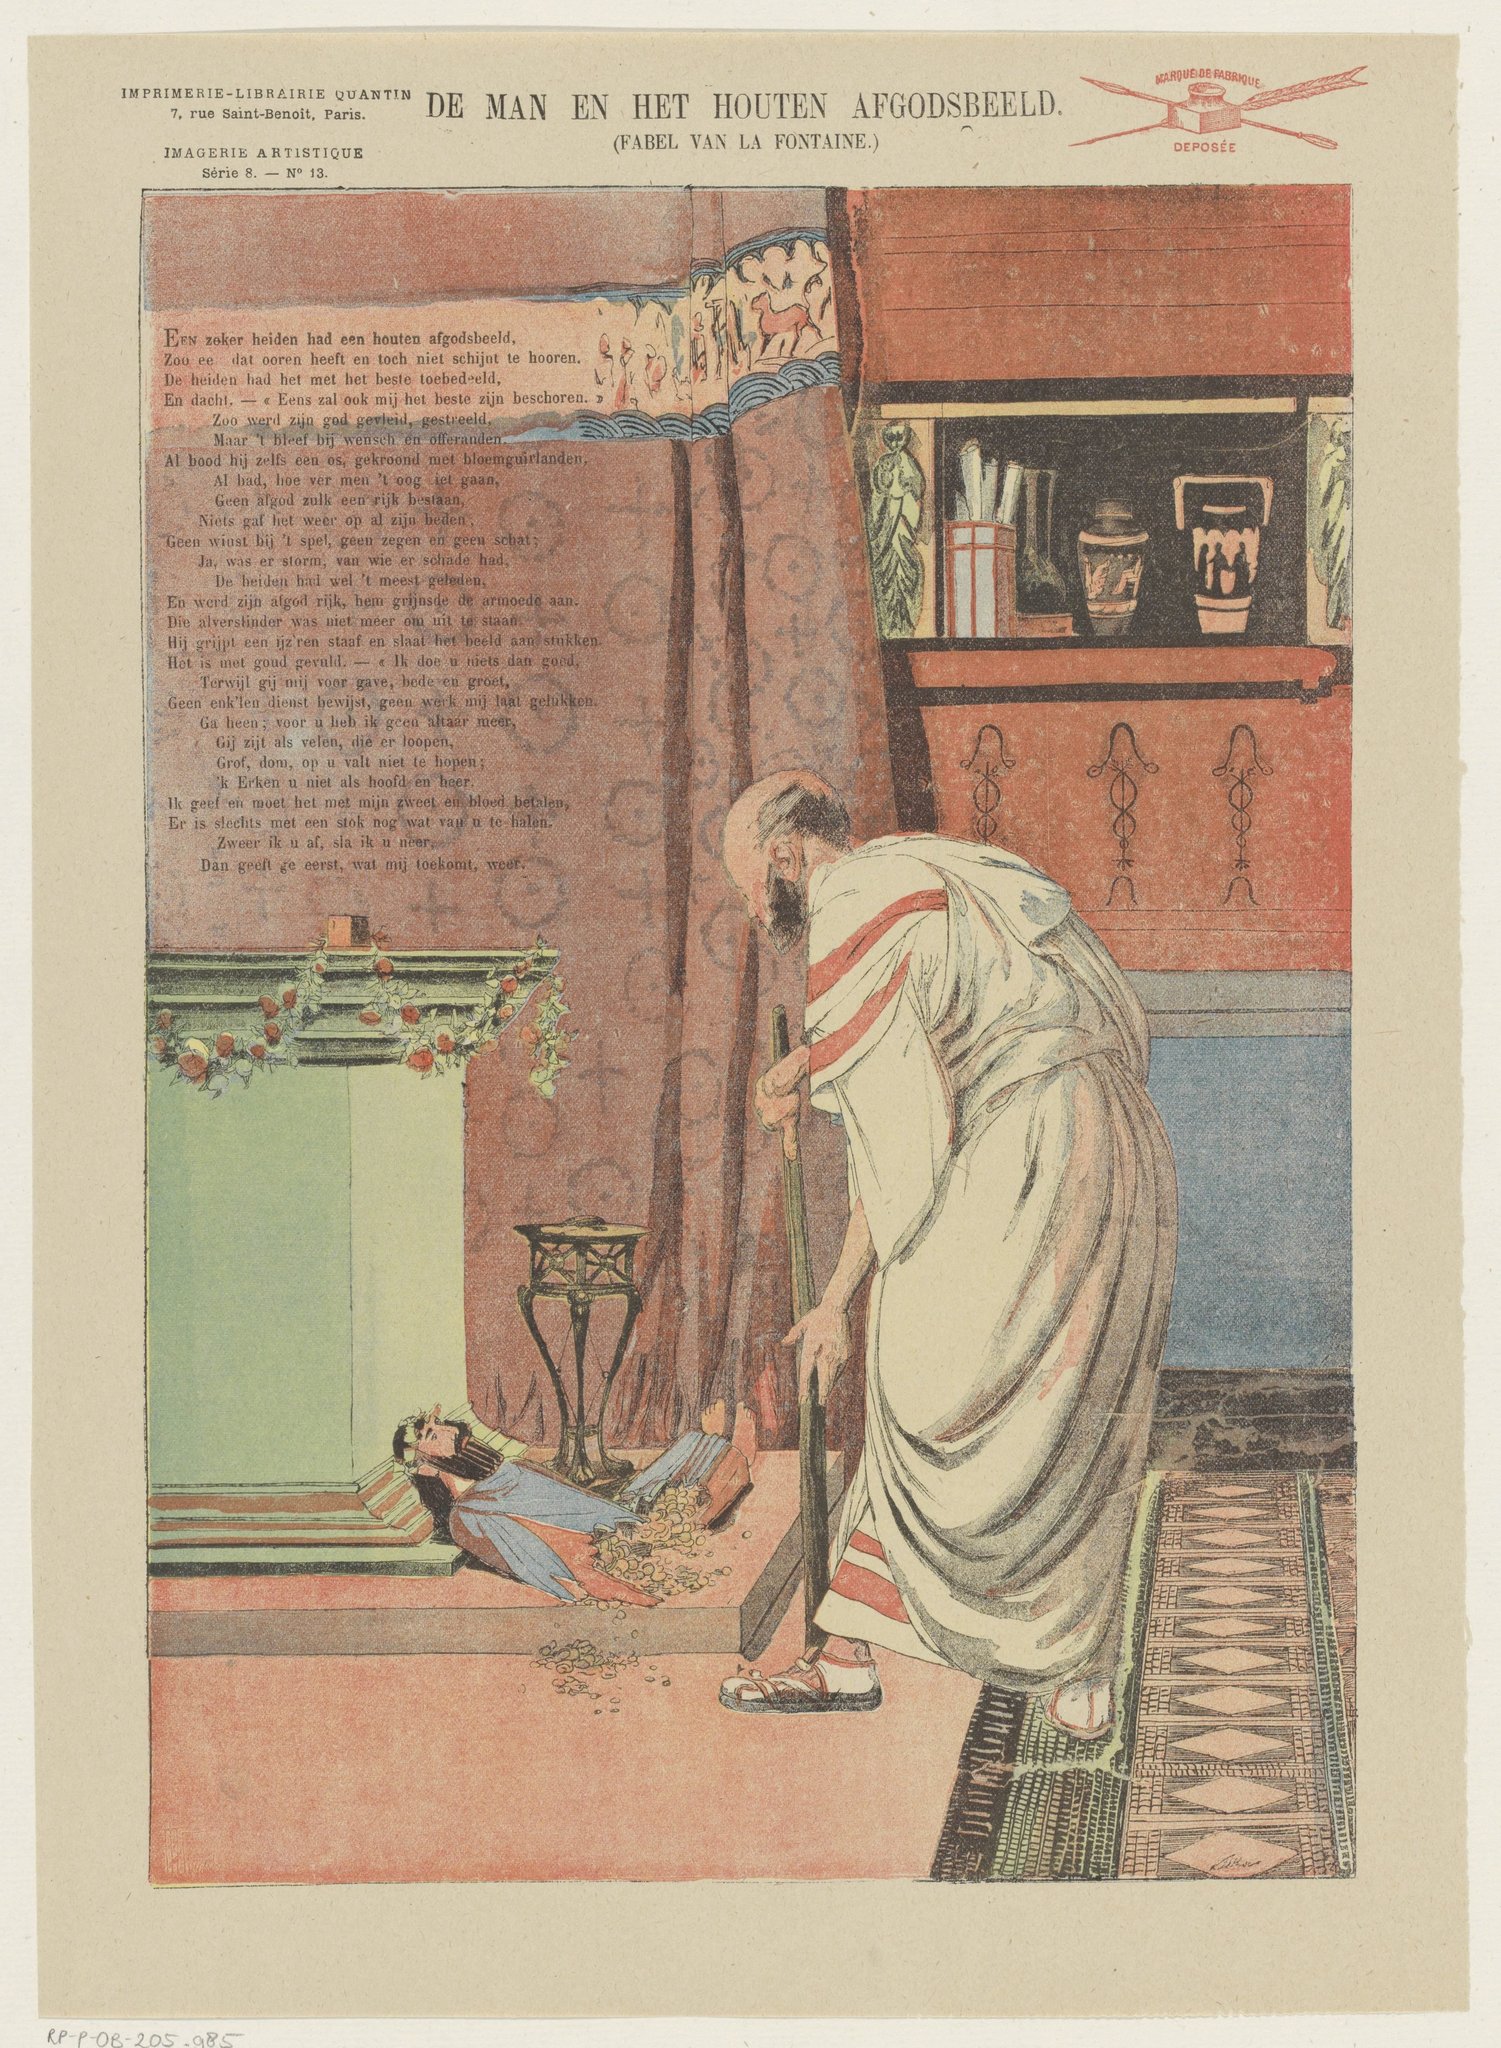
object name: popular print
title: De man en het houten afgodsbeeld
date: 1876-1890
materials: paper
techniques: lithograph, letterpress printing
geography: paris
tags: old man, monument, statue, fables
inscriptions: collector's mark: Lugt 2760, : ‘marque de fabrique / deposée’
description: Blad met een grote voorstelling uit de fabel van Jean de La Fontaine, van de man en het houten afgodsbeeld. Linksboven een vers. Genummerd linksboven: Série 8. - No. 13.